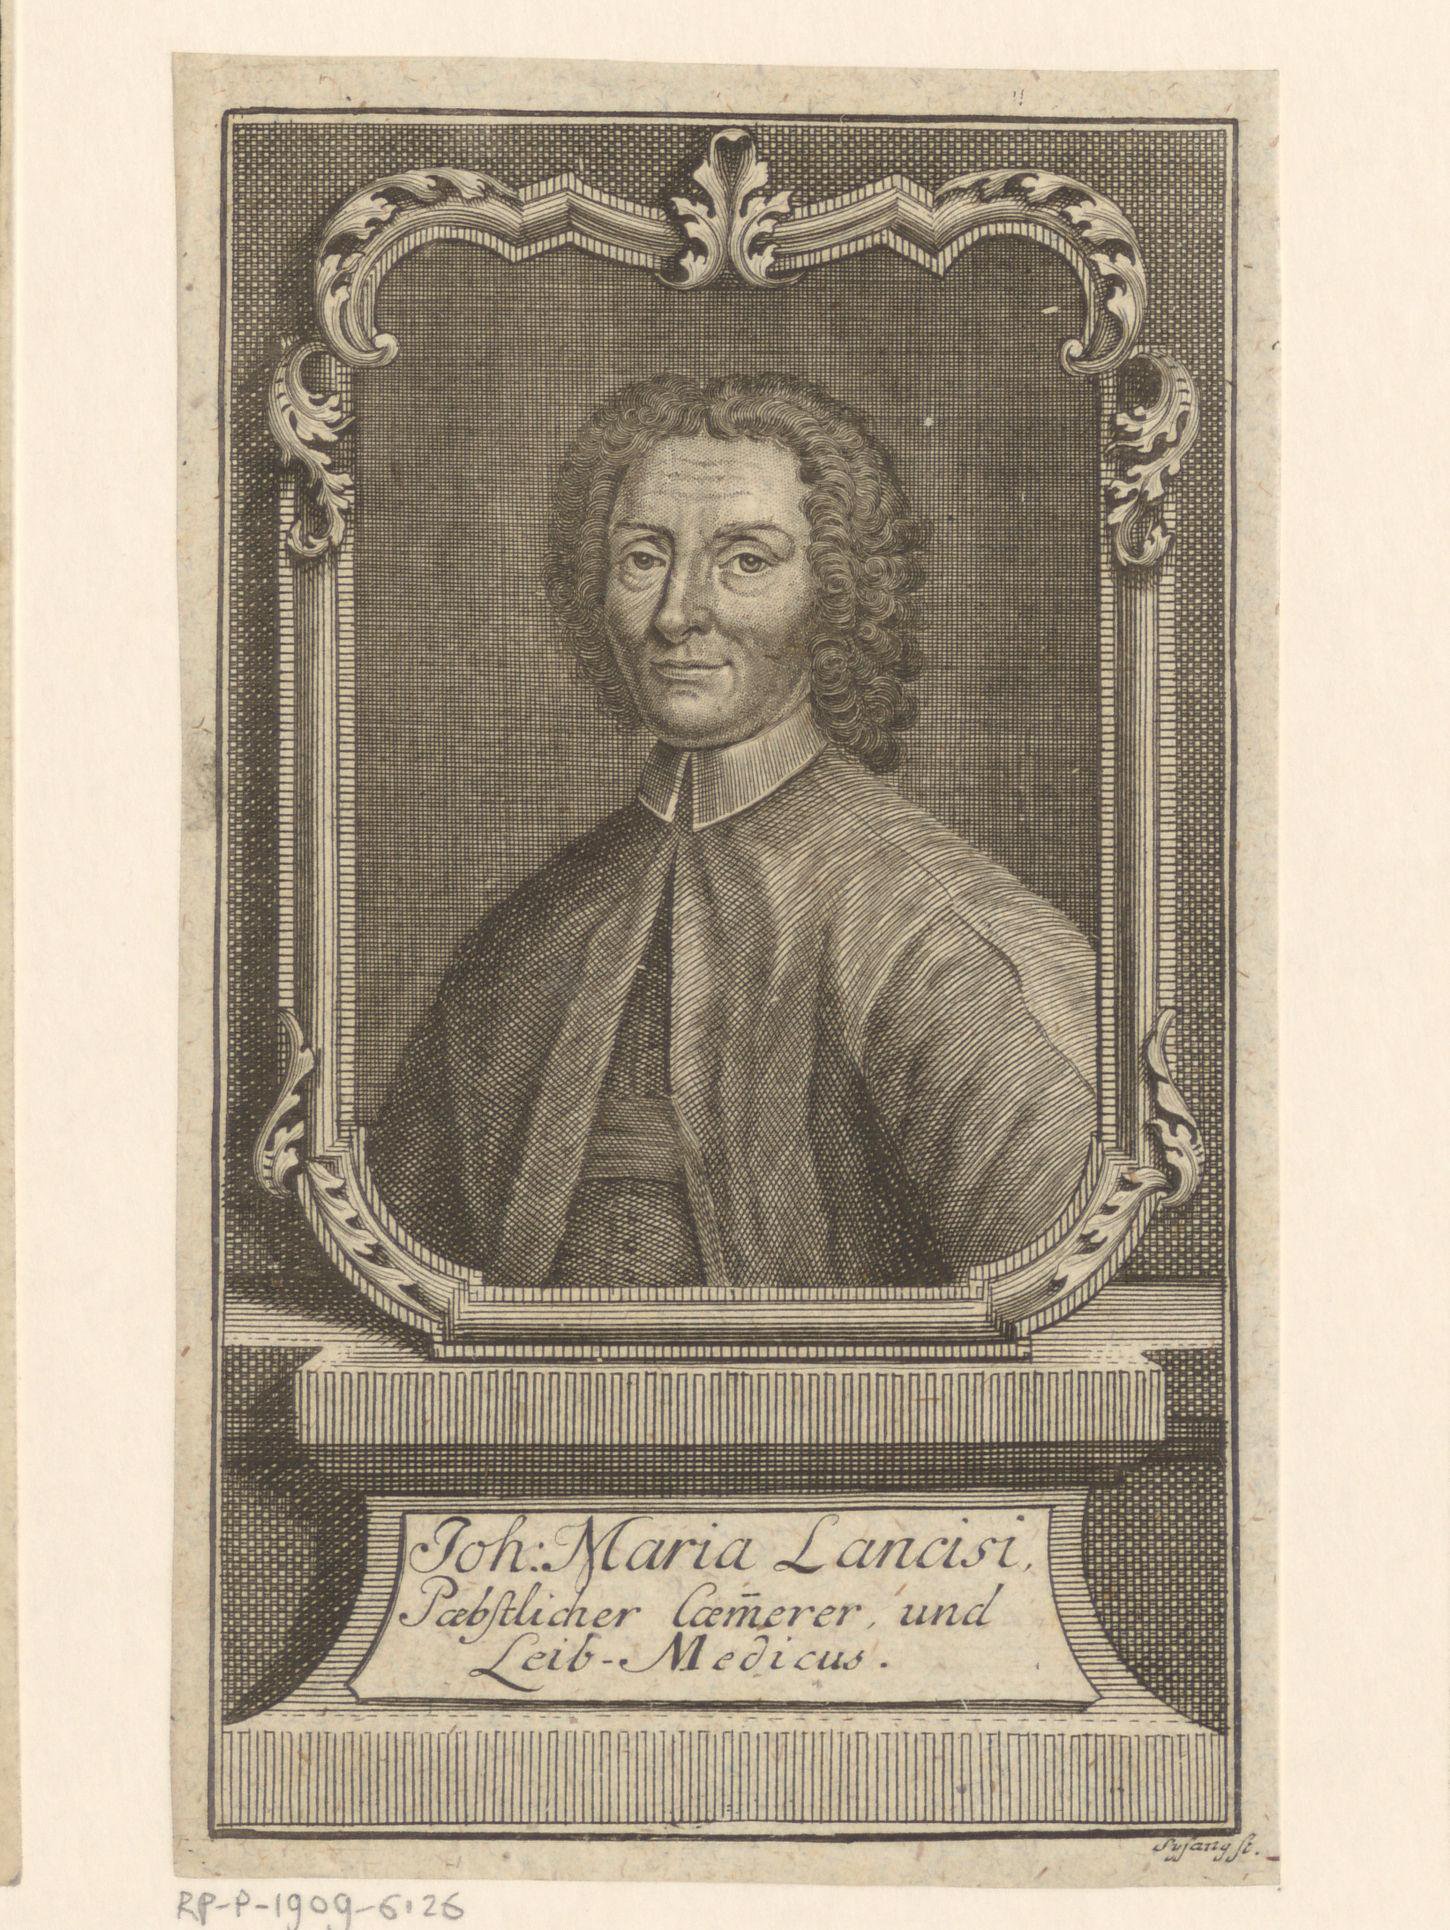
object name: print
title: Portret van Giovanni Maria Lancisi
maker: johann christoph sysang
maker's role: print maker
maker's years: 1703-1757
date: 1713-1757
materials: paper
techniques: engraving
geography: germany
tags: rome, historical persons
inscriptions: collector's mark: Lugt 2228